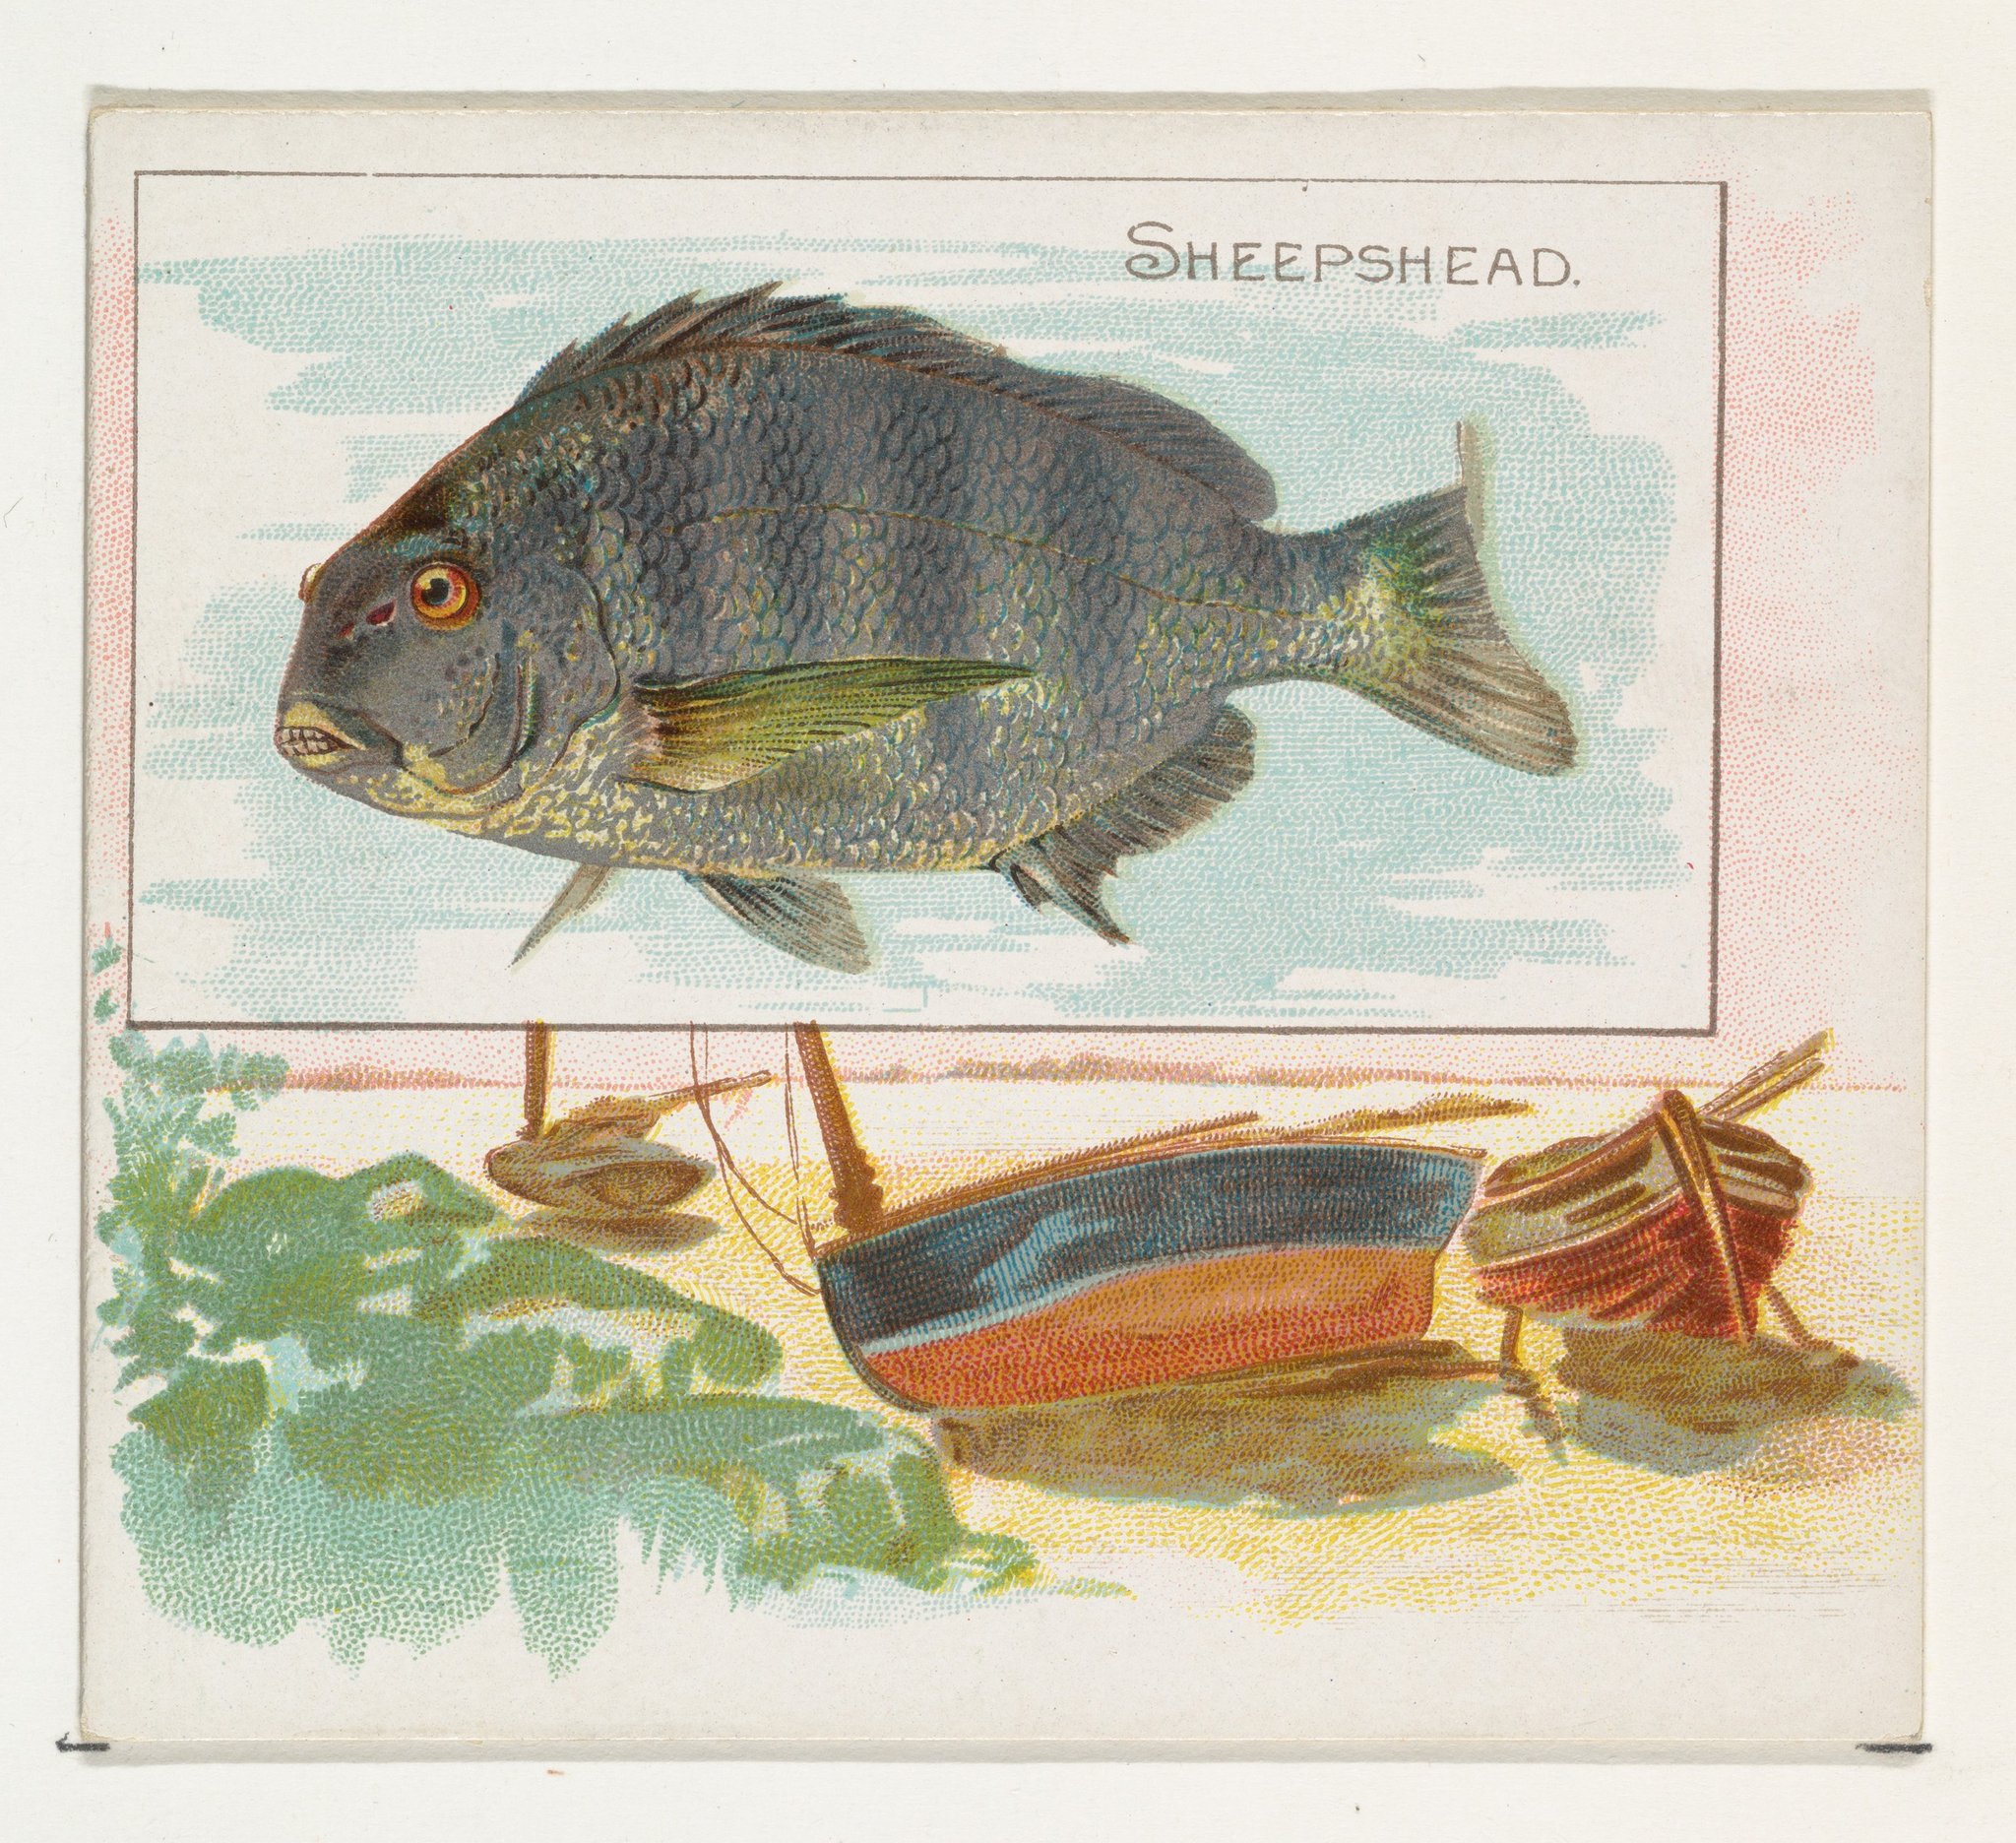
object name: print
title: Sheepshead, from Fish from American Waters series (N39) for Allen & Ginter Cigarettes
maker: allen & ginter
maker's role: publisher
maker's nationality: american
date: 1889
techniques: color lithograph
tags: fish